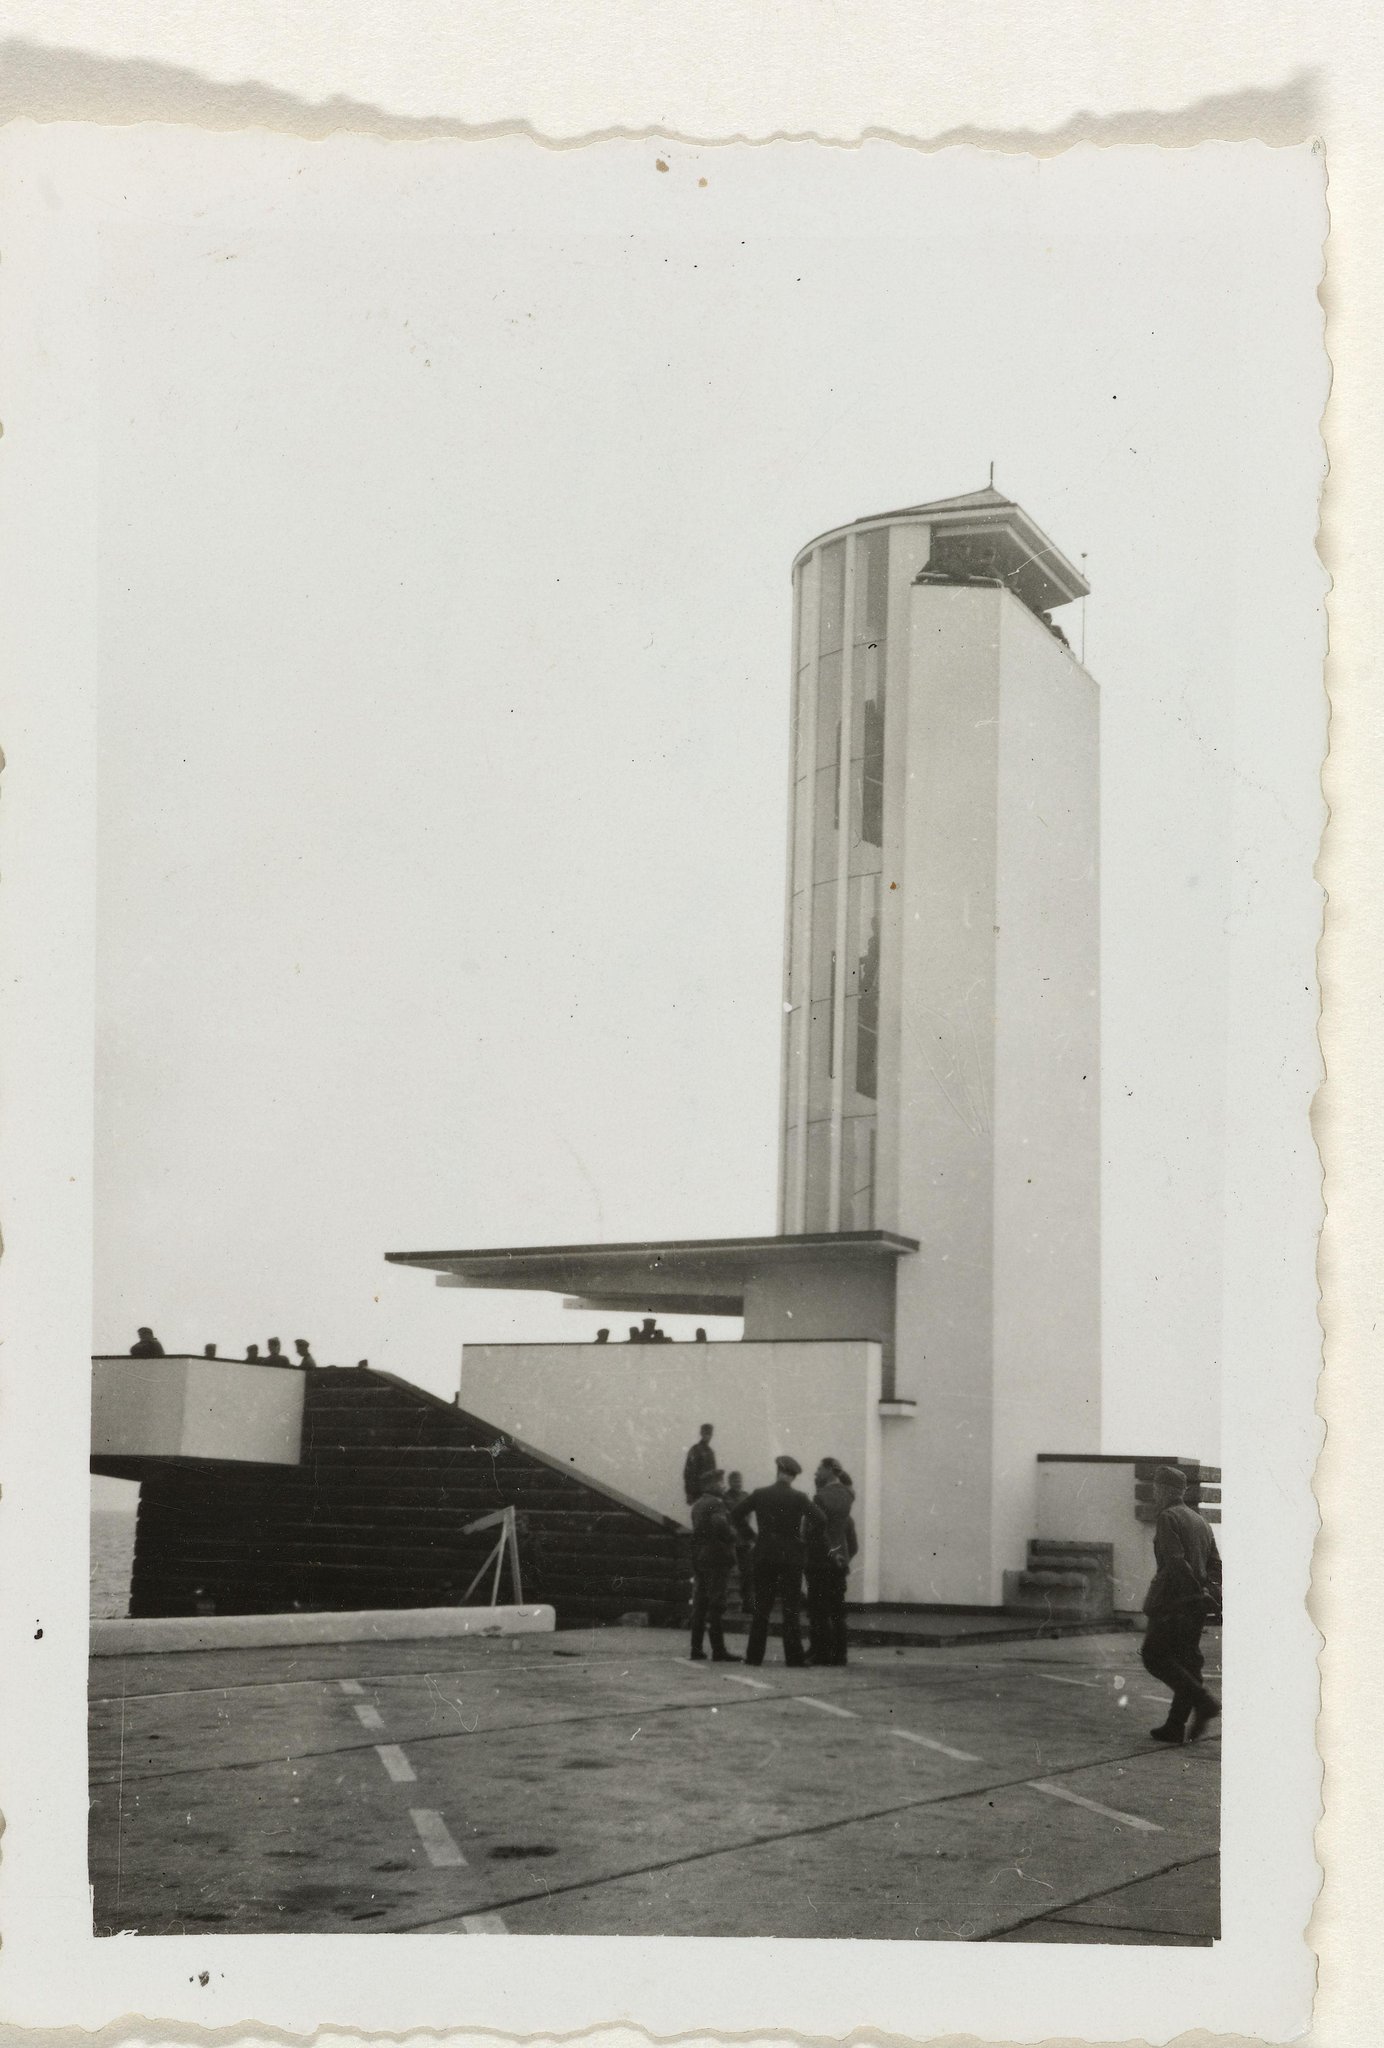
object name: photograph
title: Wehrmacht militairen op de Afsluitdijk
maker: Anonymous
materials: photographic support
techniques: gelatin silver print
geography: afsluitdijk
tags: occupation ~ war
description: Duitse militairen staan bij het monument op de Afsluitdijk. Het monument, ontworpen door Dudok, is gebouwd op de plaats waar de Afsluitdijk gedicht werd in 1932. Achterop staat: Holland. Am See, Vünfter Treppe bin ich 60 m. über wasser.